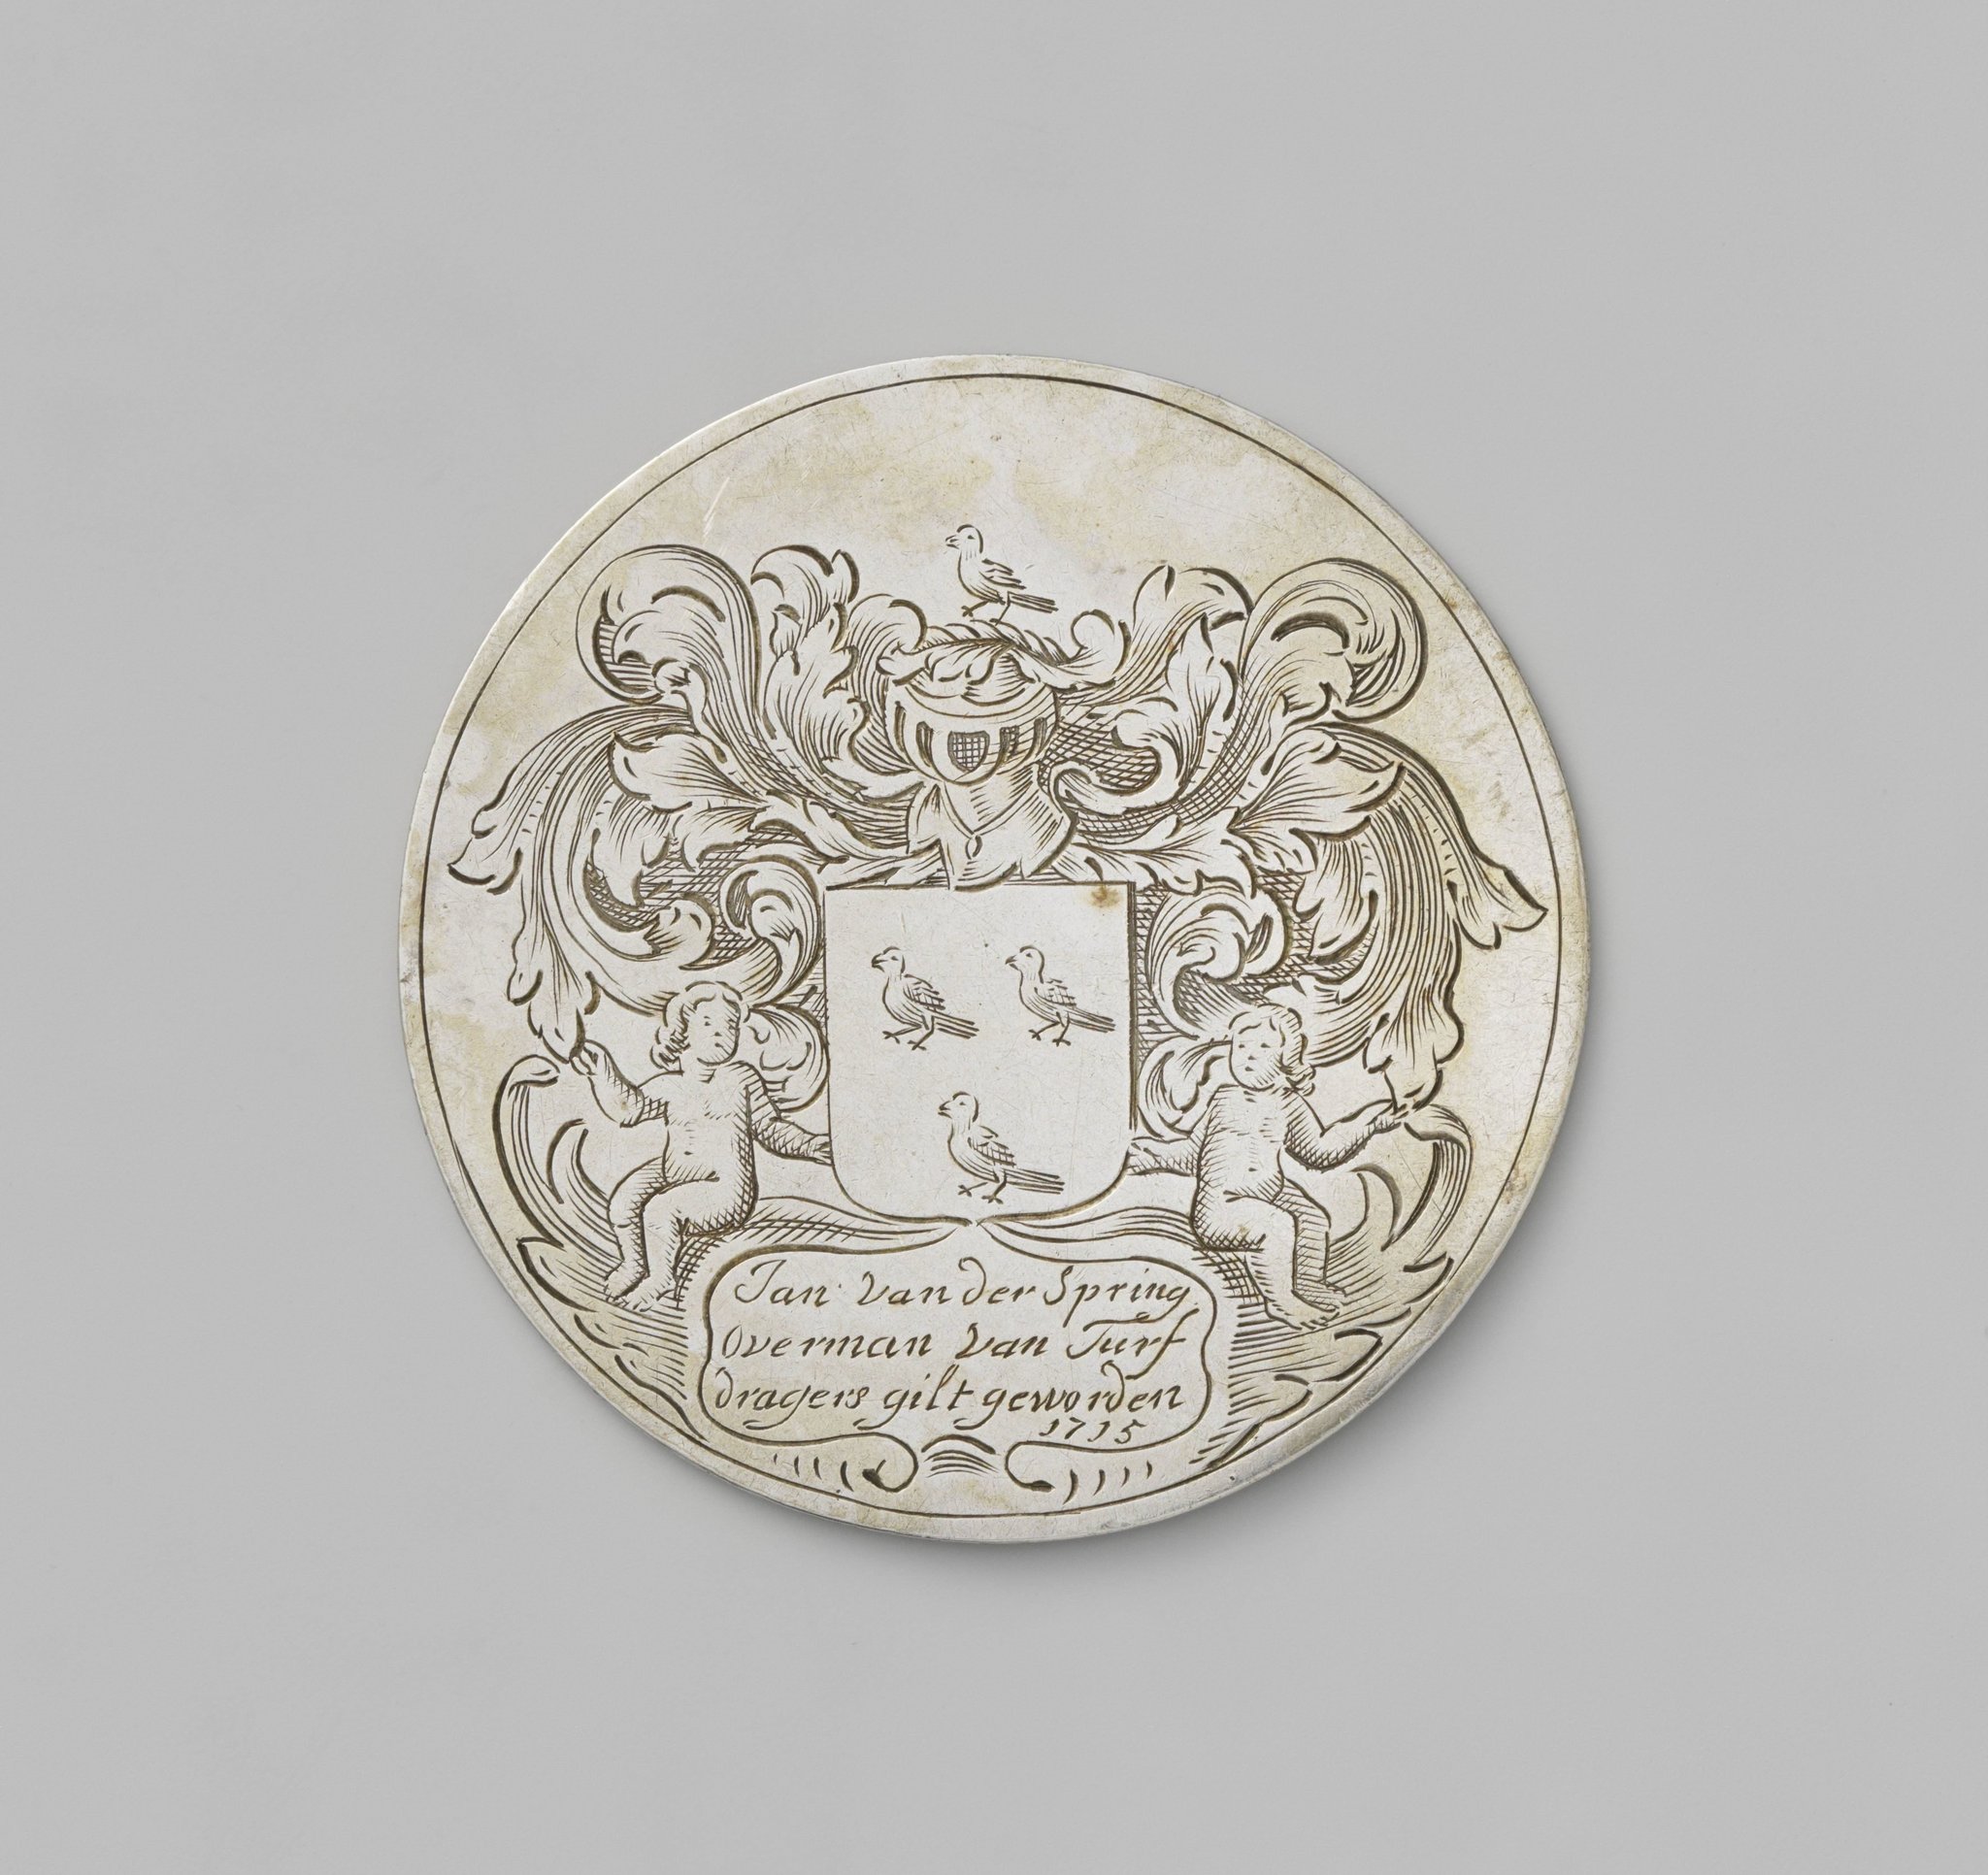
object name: overmanspenning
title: Peat Porters’ Guild, with the name of Jan van der Spring, Master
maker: Anonymous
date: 1715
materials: silver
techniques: engraving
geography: amsterdam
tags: amsterdam